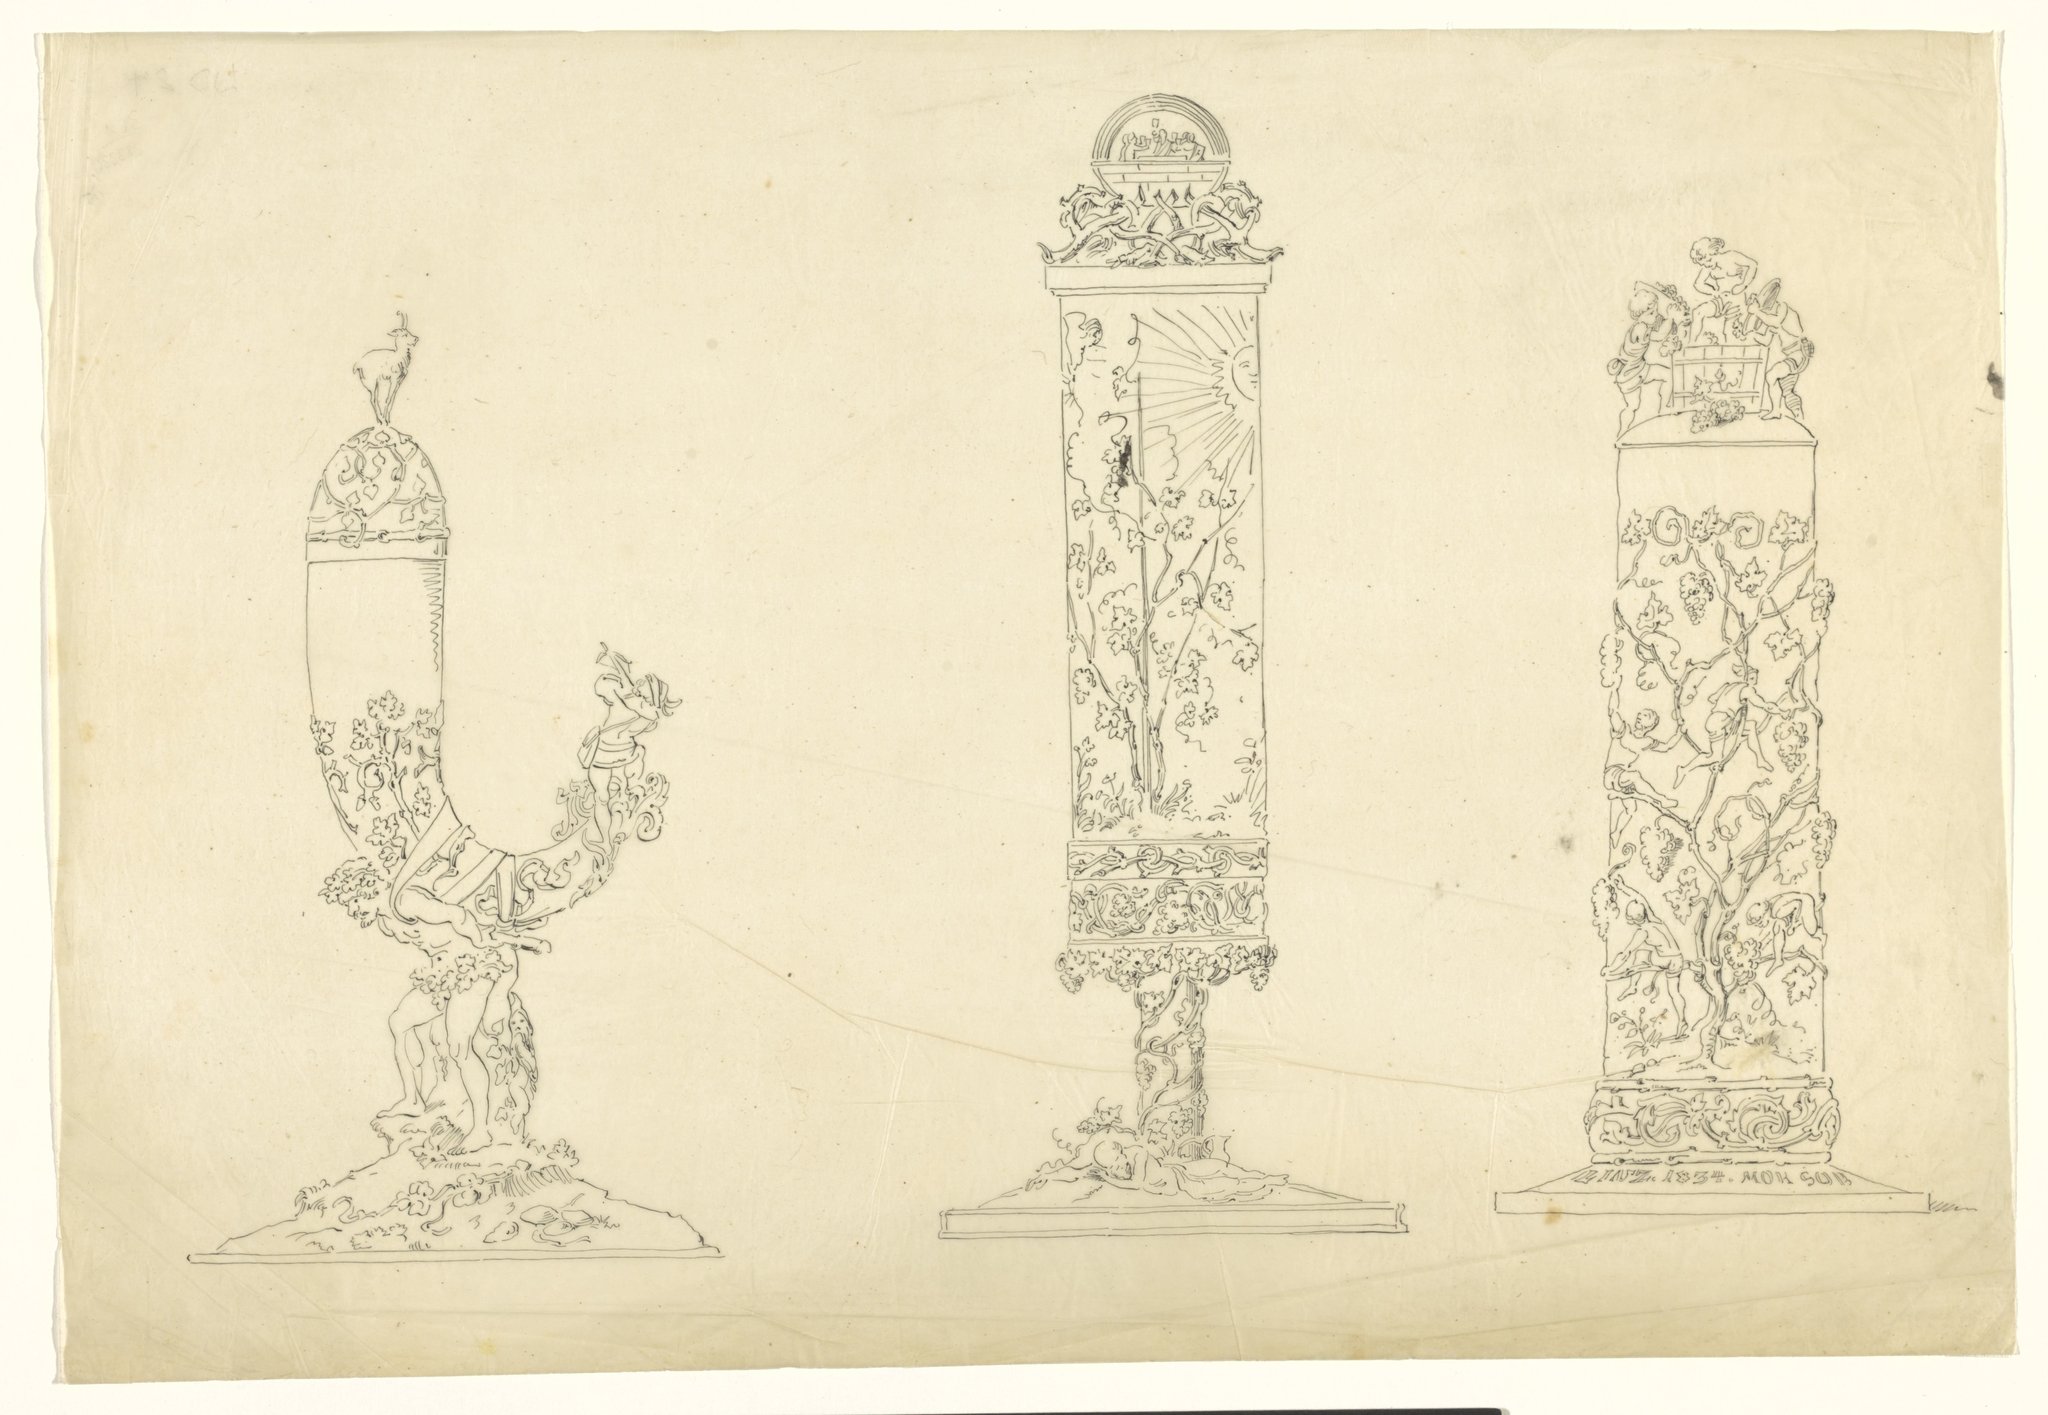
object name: drawing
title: Drinkhoorn met een stam in de vorm van een dragende Bacchus, een cylindrische dekselbokaal met een zonovergoten landschap, en een cylindrische dekselbeker met jongens die in wijnbomen klimmen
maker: franz jakob kreuter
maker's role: architect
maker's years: 1813-1889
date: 1835-1860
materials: ink, paper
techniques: pen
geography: vienna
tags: mug, beaker, goblet, drinking-horn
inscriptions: edge inscription: ‘LINZ.1834.MON SOR.’